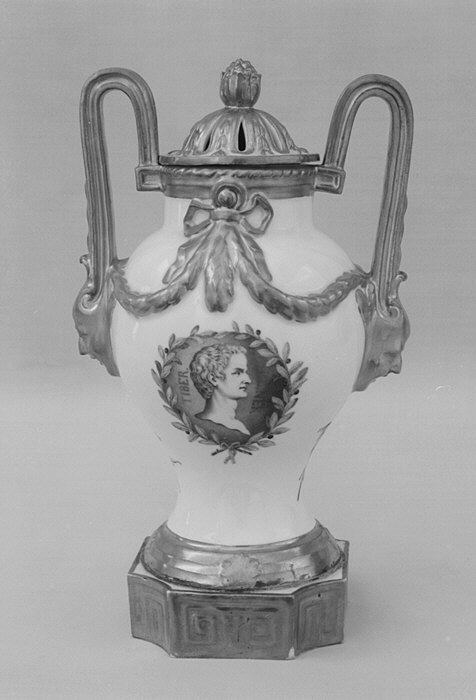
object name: vase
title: Vase (part of a garniture)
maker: fürstenberg porcelain manufactory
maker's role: manufactory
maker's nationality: german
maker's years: 1747-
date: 1780-1790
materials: hard paste porcelain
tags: men,profiles